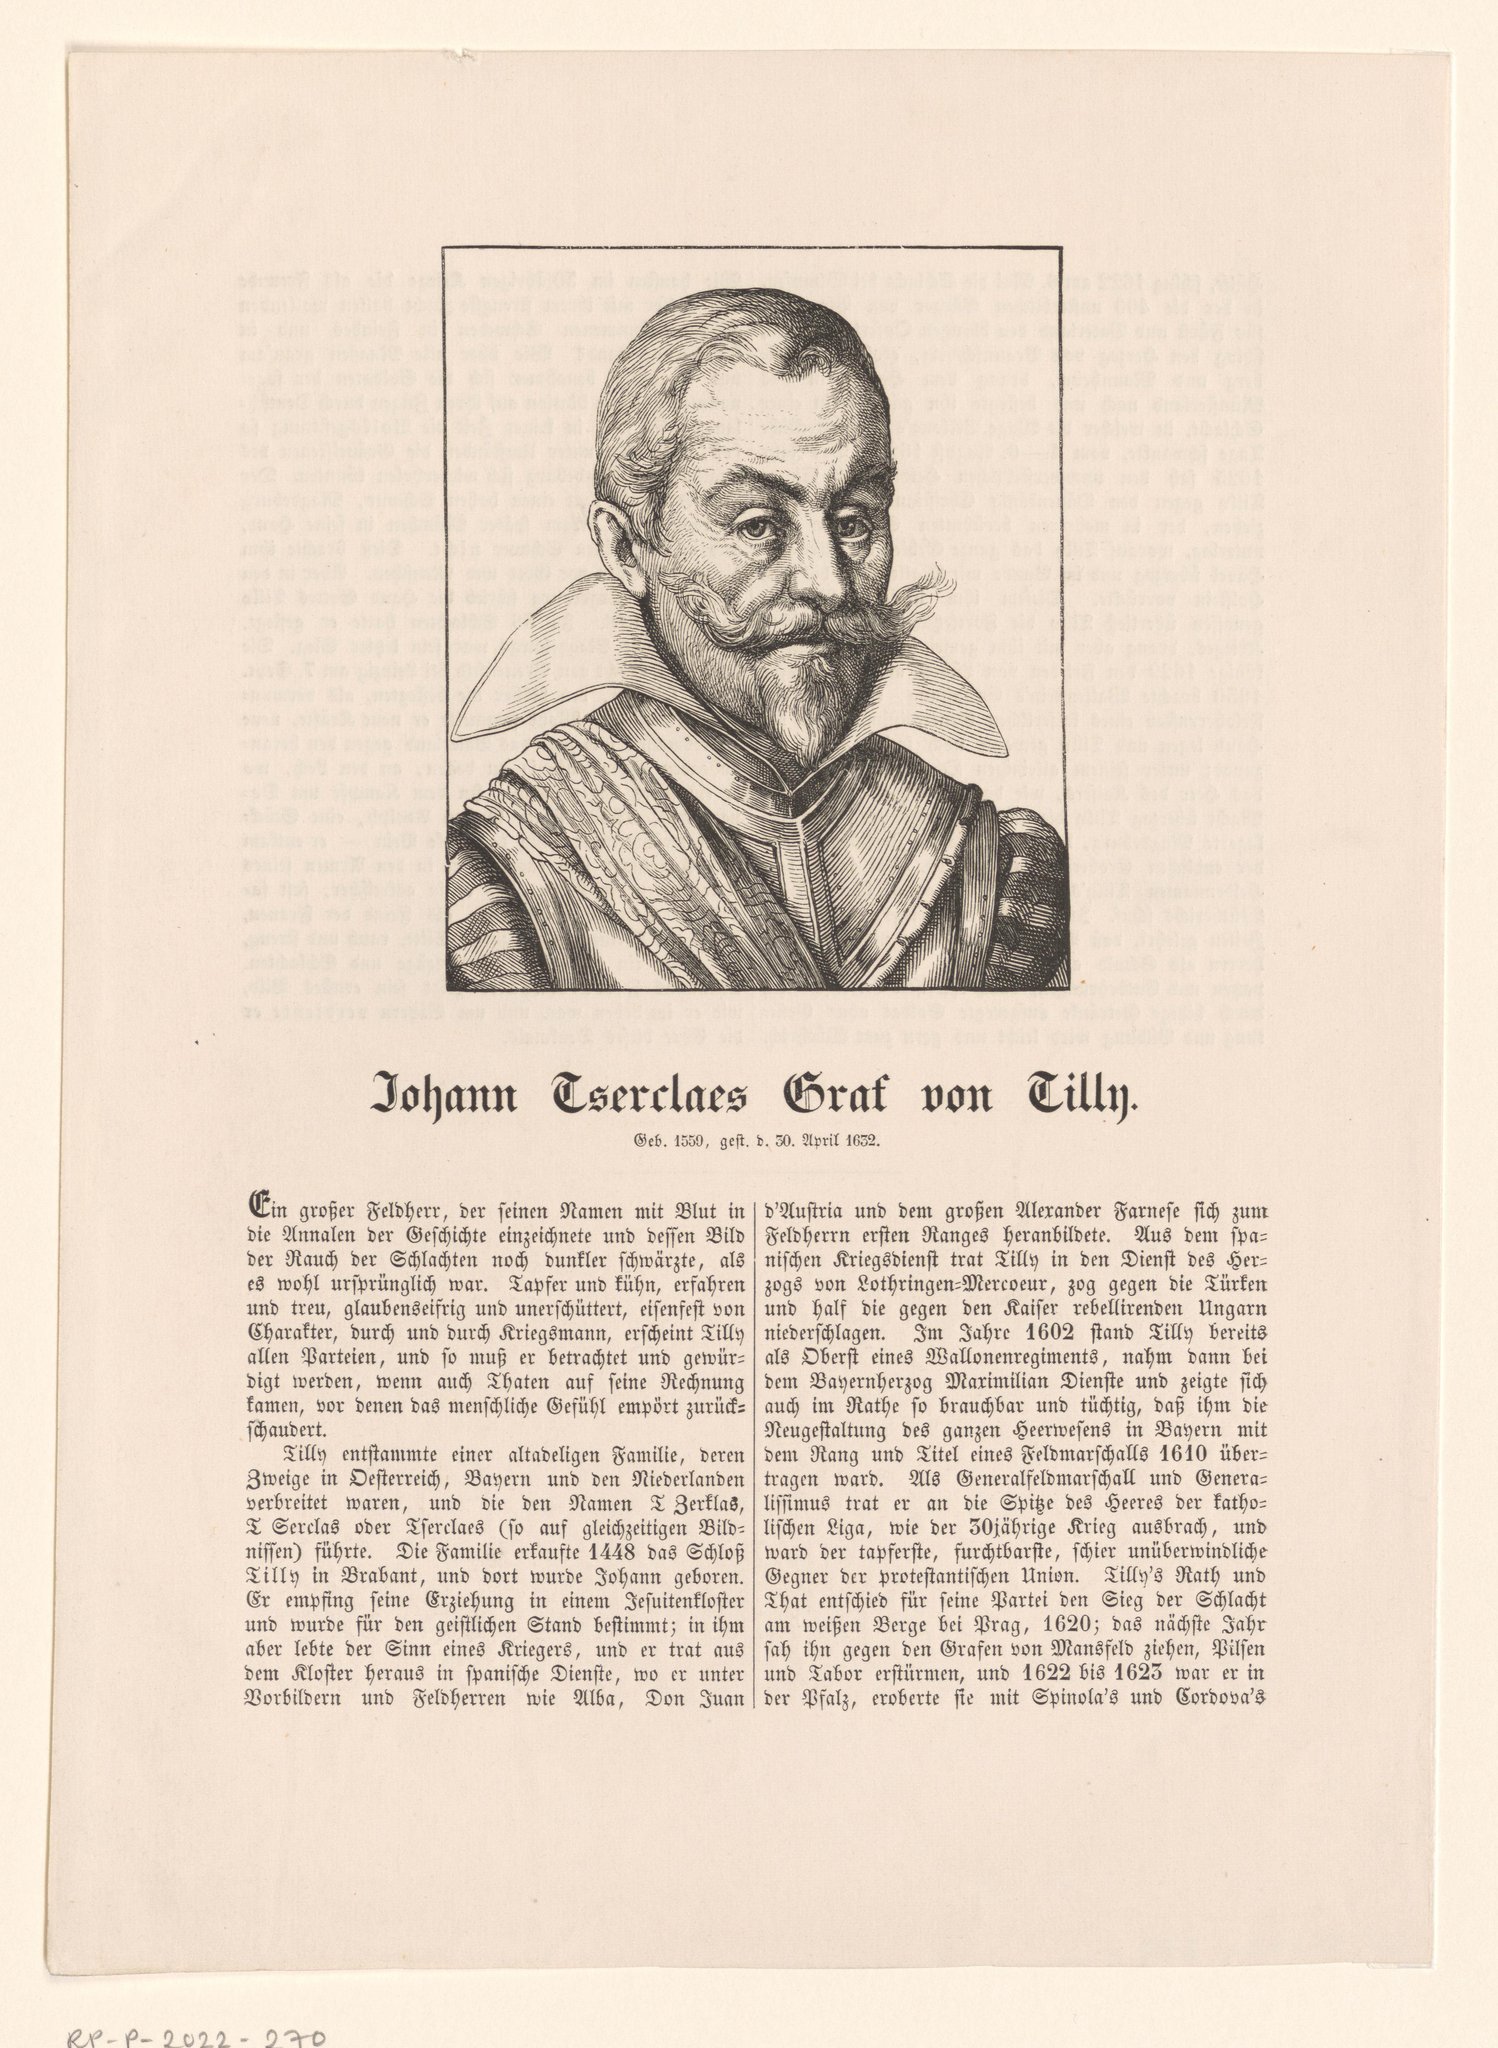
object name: book illustration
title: Portret van Johan t'Serclaes, graaf van Tilly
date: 1854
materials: paper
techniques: letterpress printing, engraving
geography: leipzig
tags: commander-in-chief, general, marshal, historical persons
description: Prent uit: Bechstein, Ludwig. Zweihundert deutsche Männer in Bildnissen und Lebensbeschreibungen. Leipzig: Georg Wigand, 1854.